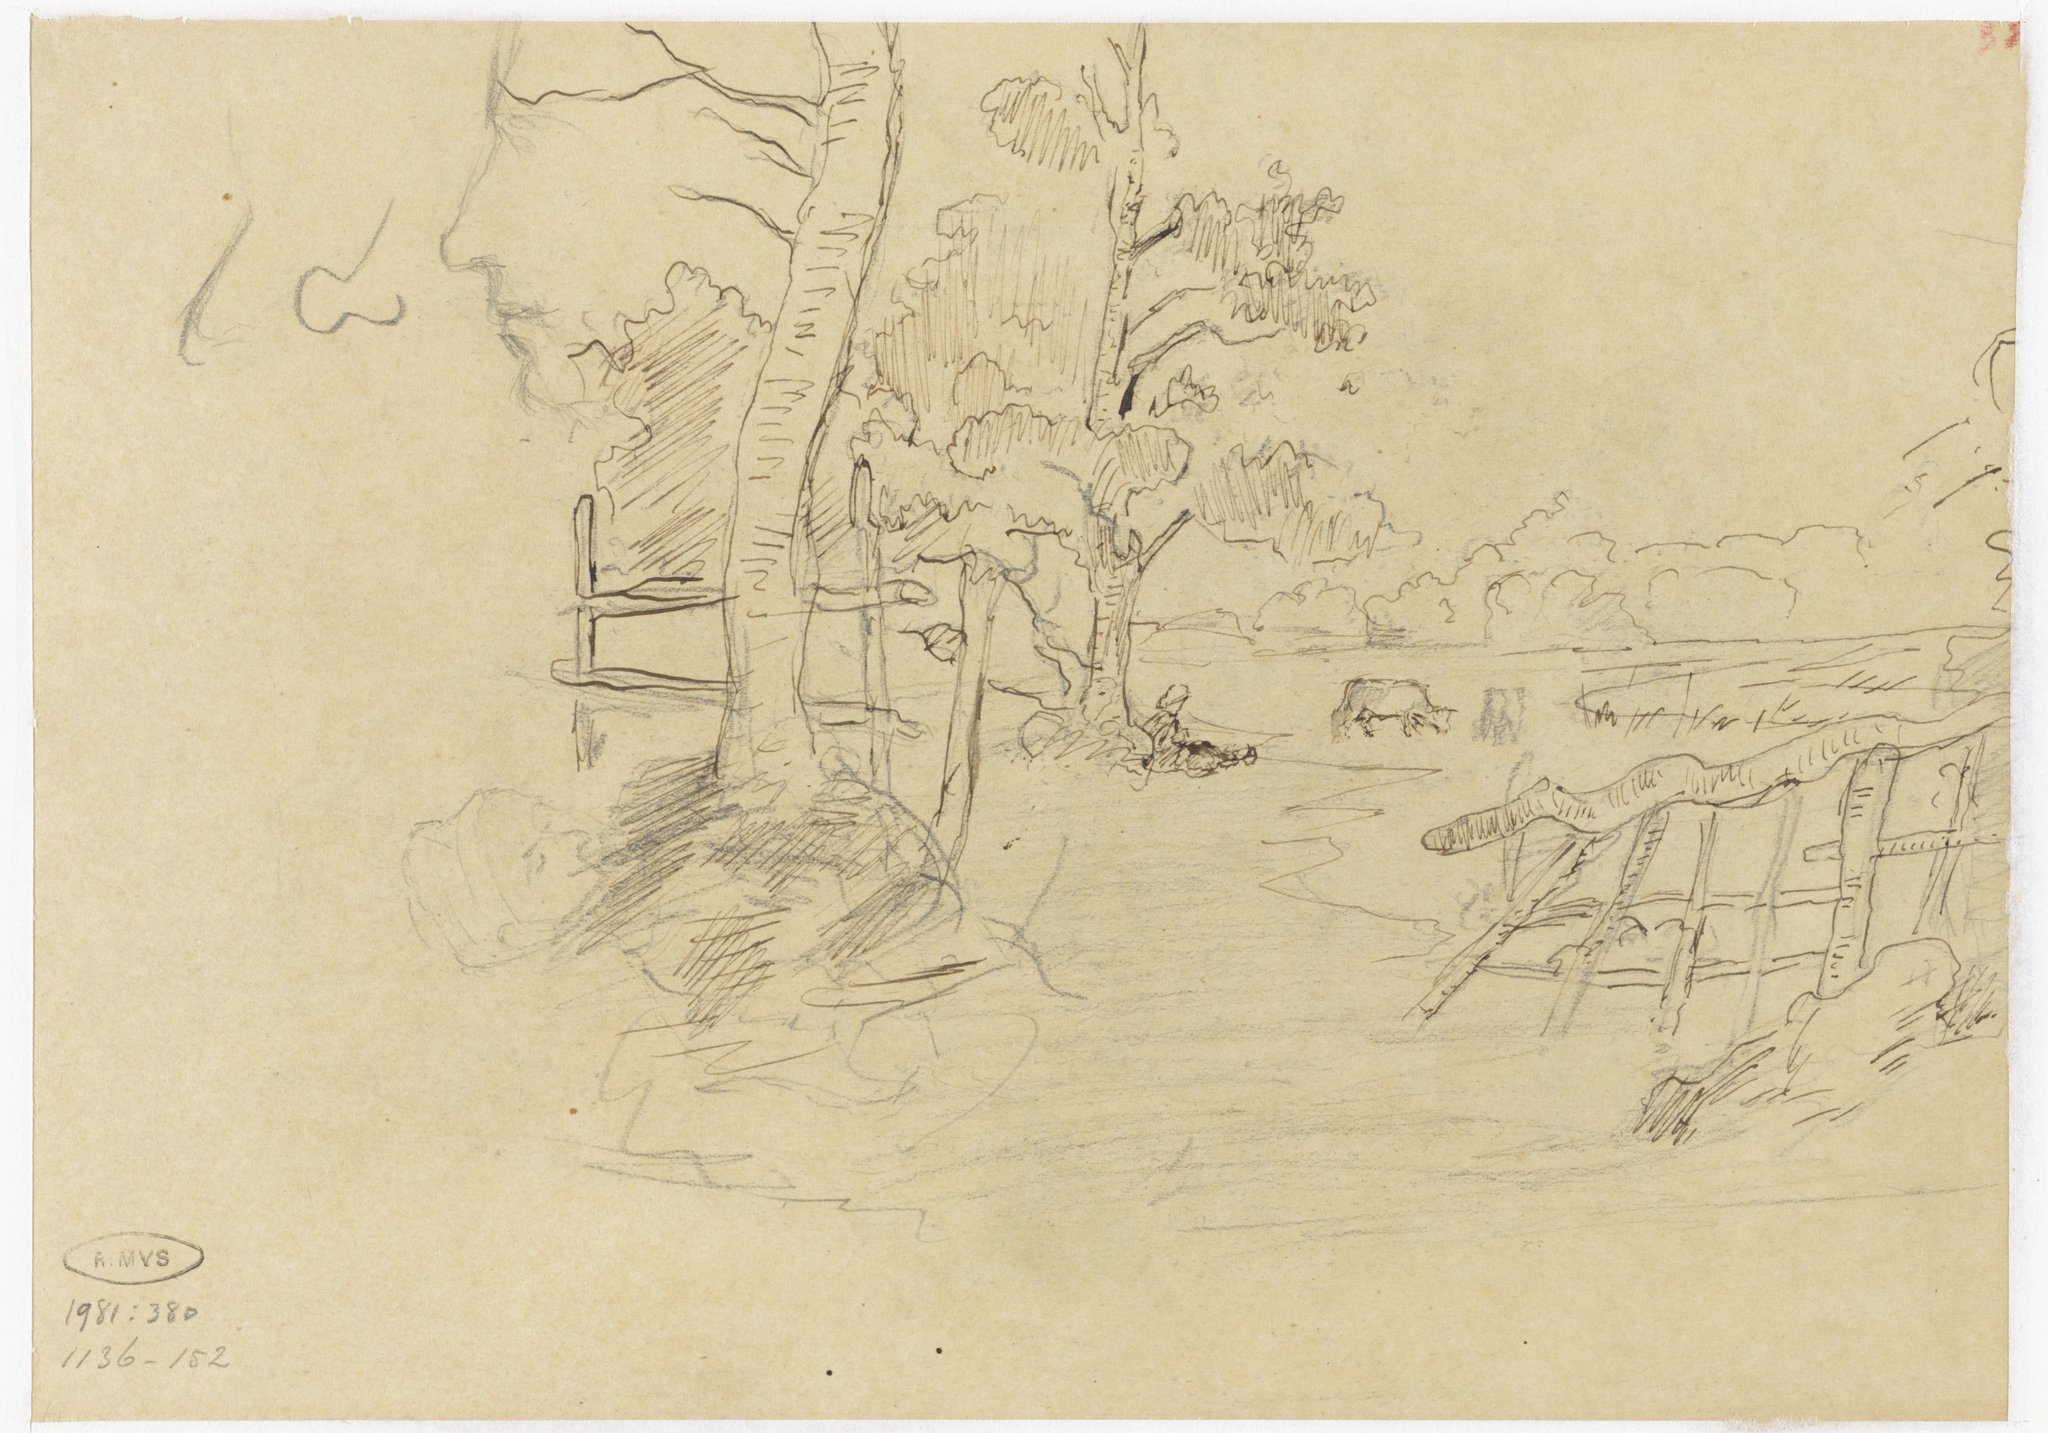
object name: drawing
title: Weiden met bomen en een hek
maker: jozef israëls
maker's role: draughtsman, painter, print maker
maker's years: 1824-1911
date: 1834-1911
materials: ink, paper, pencil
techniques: pen